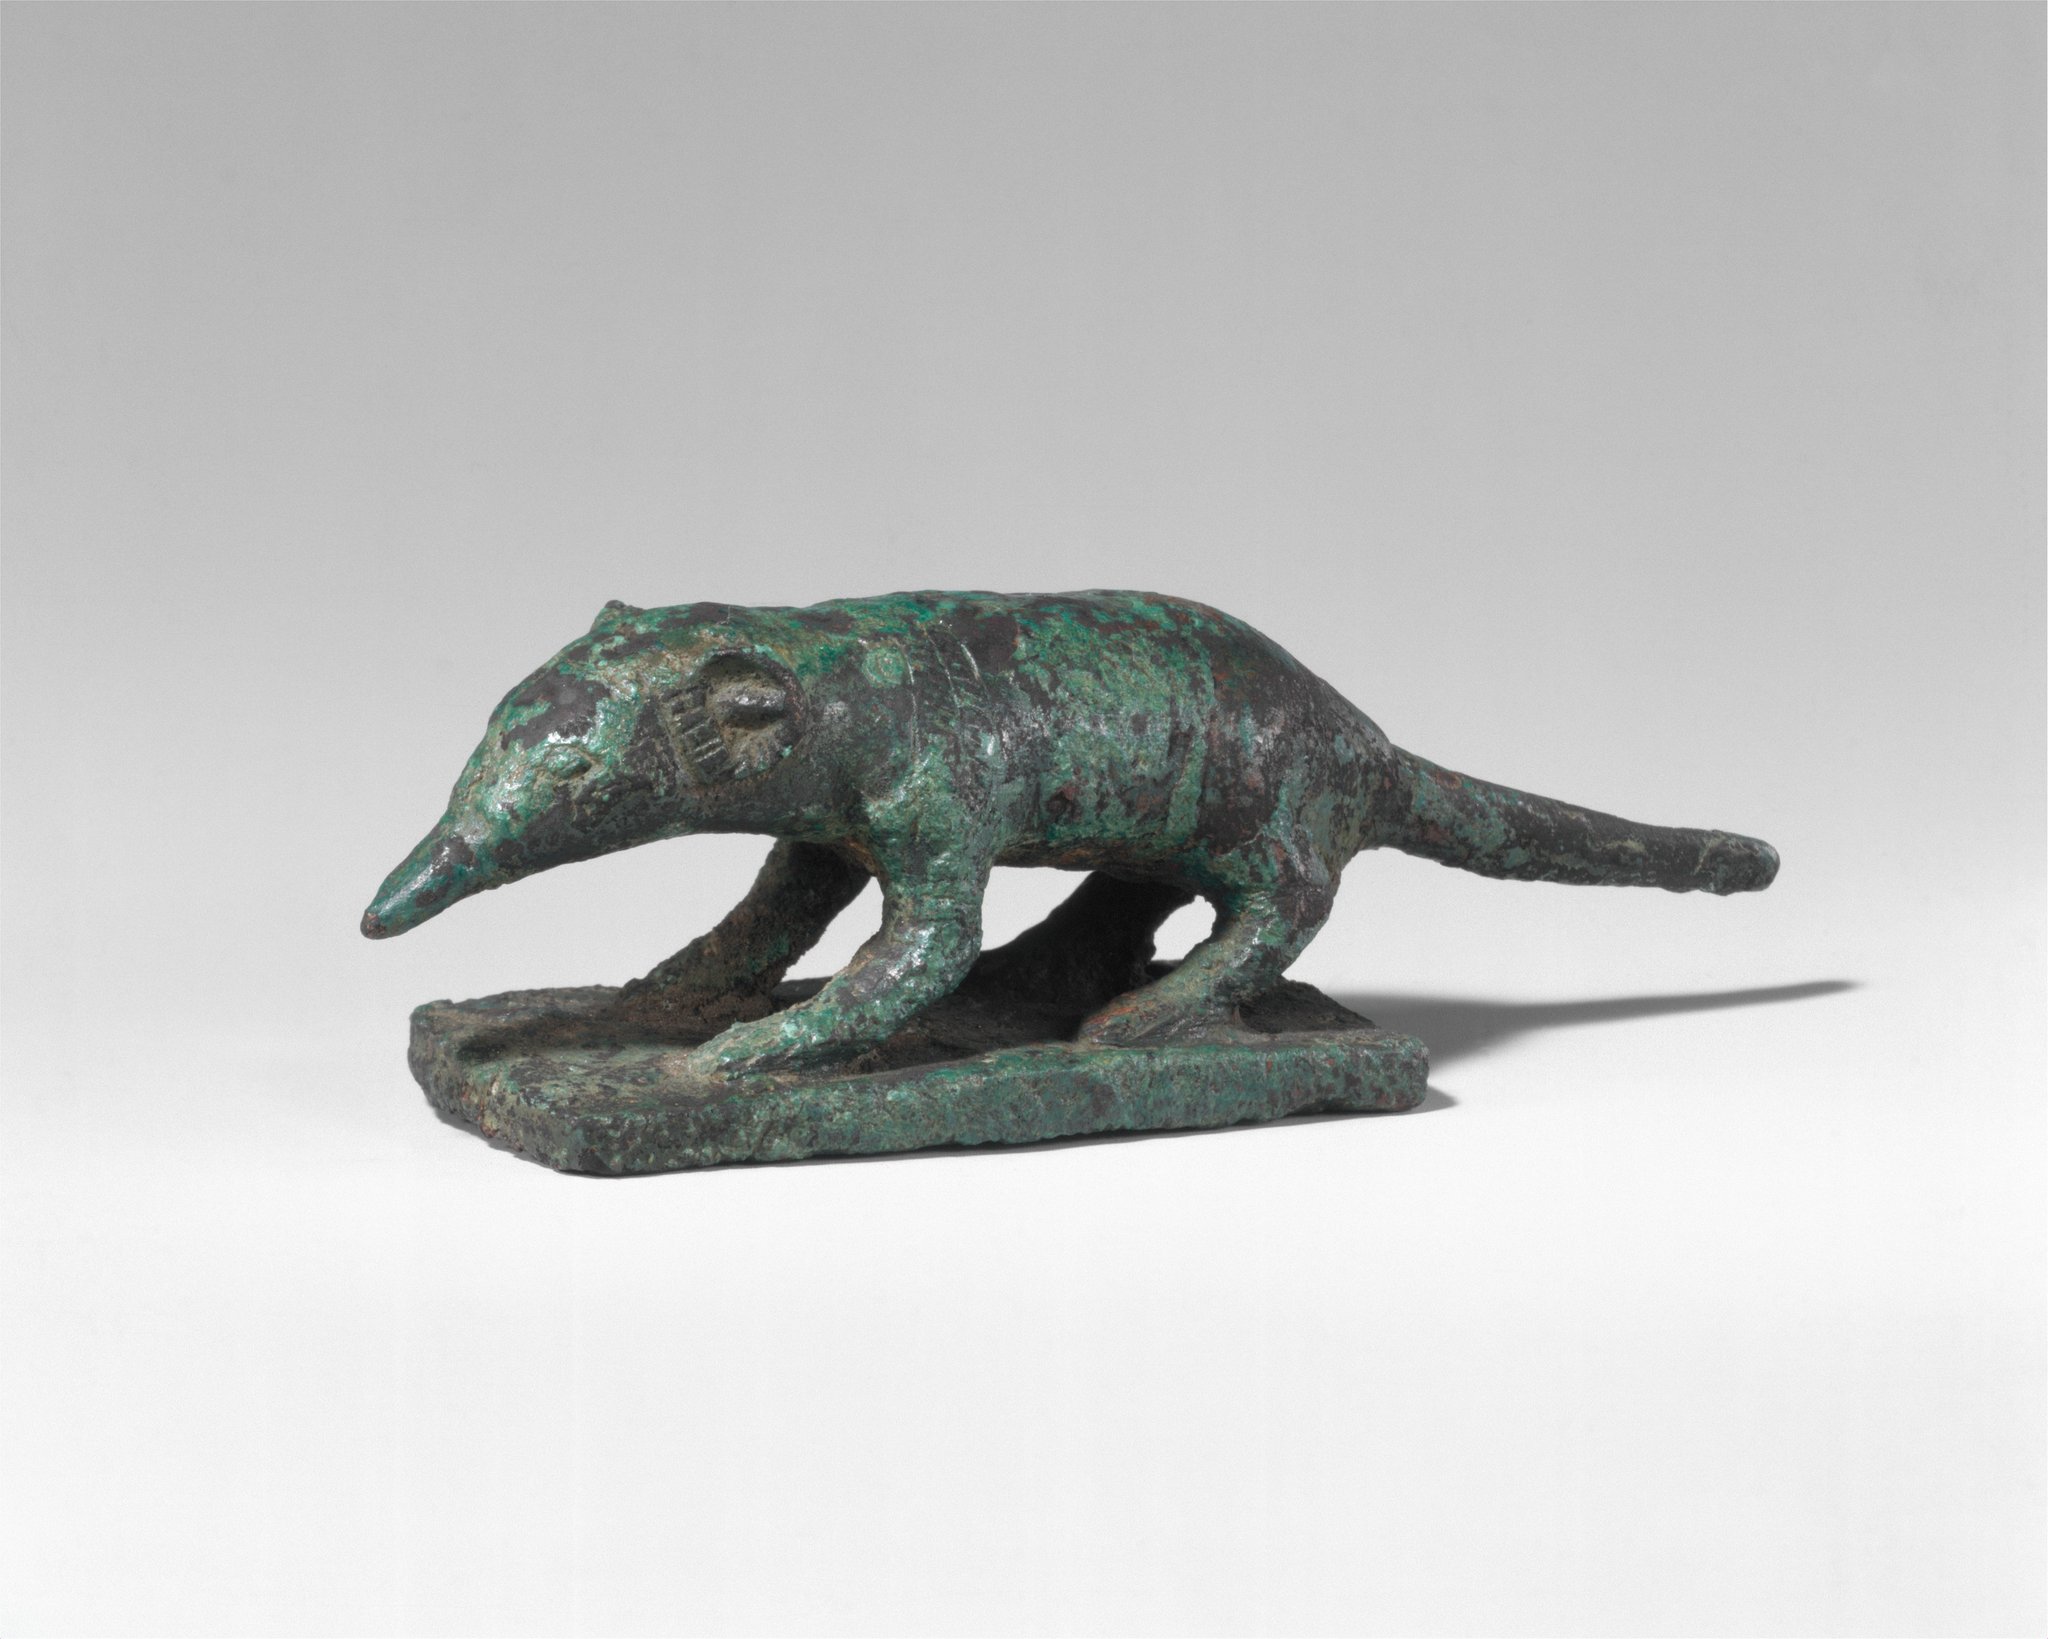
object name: figurine, shrew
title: Figure of a Shrew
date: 304-30 BCE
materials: metal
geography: egypt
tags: animals